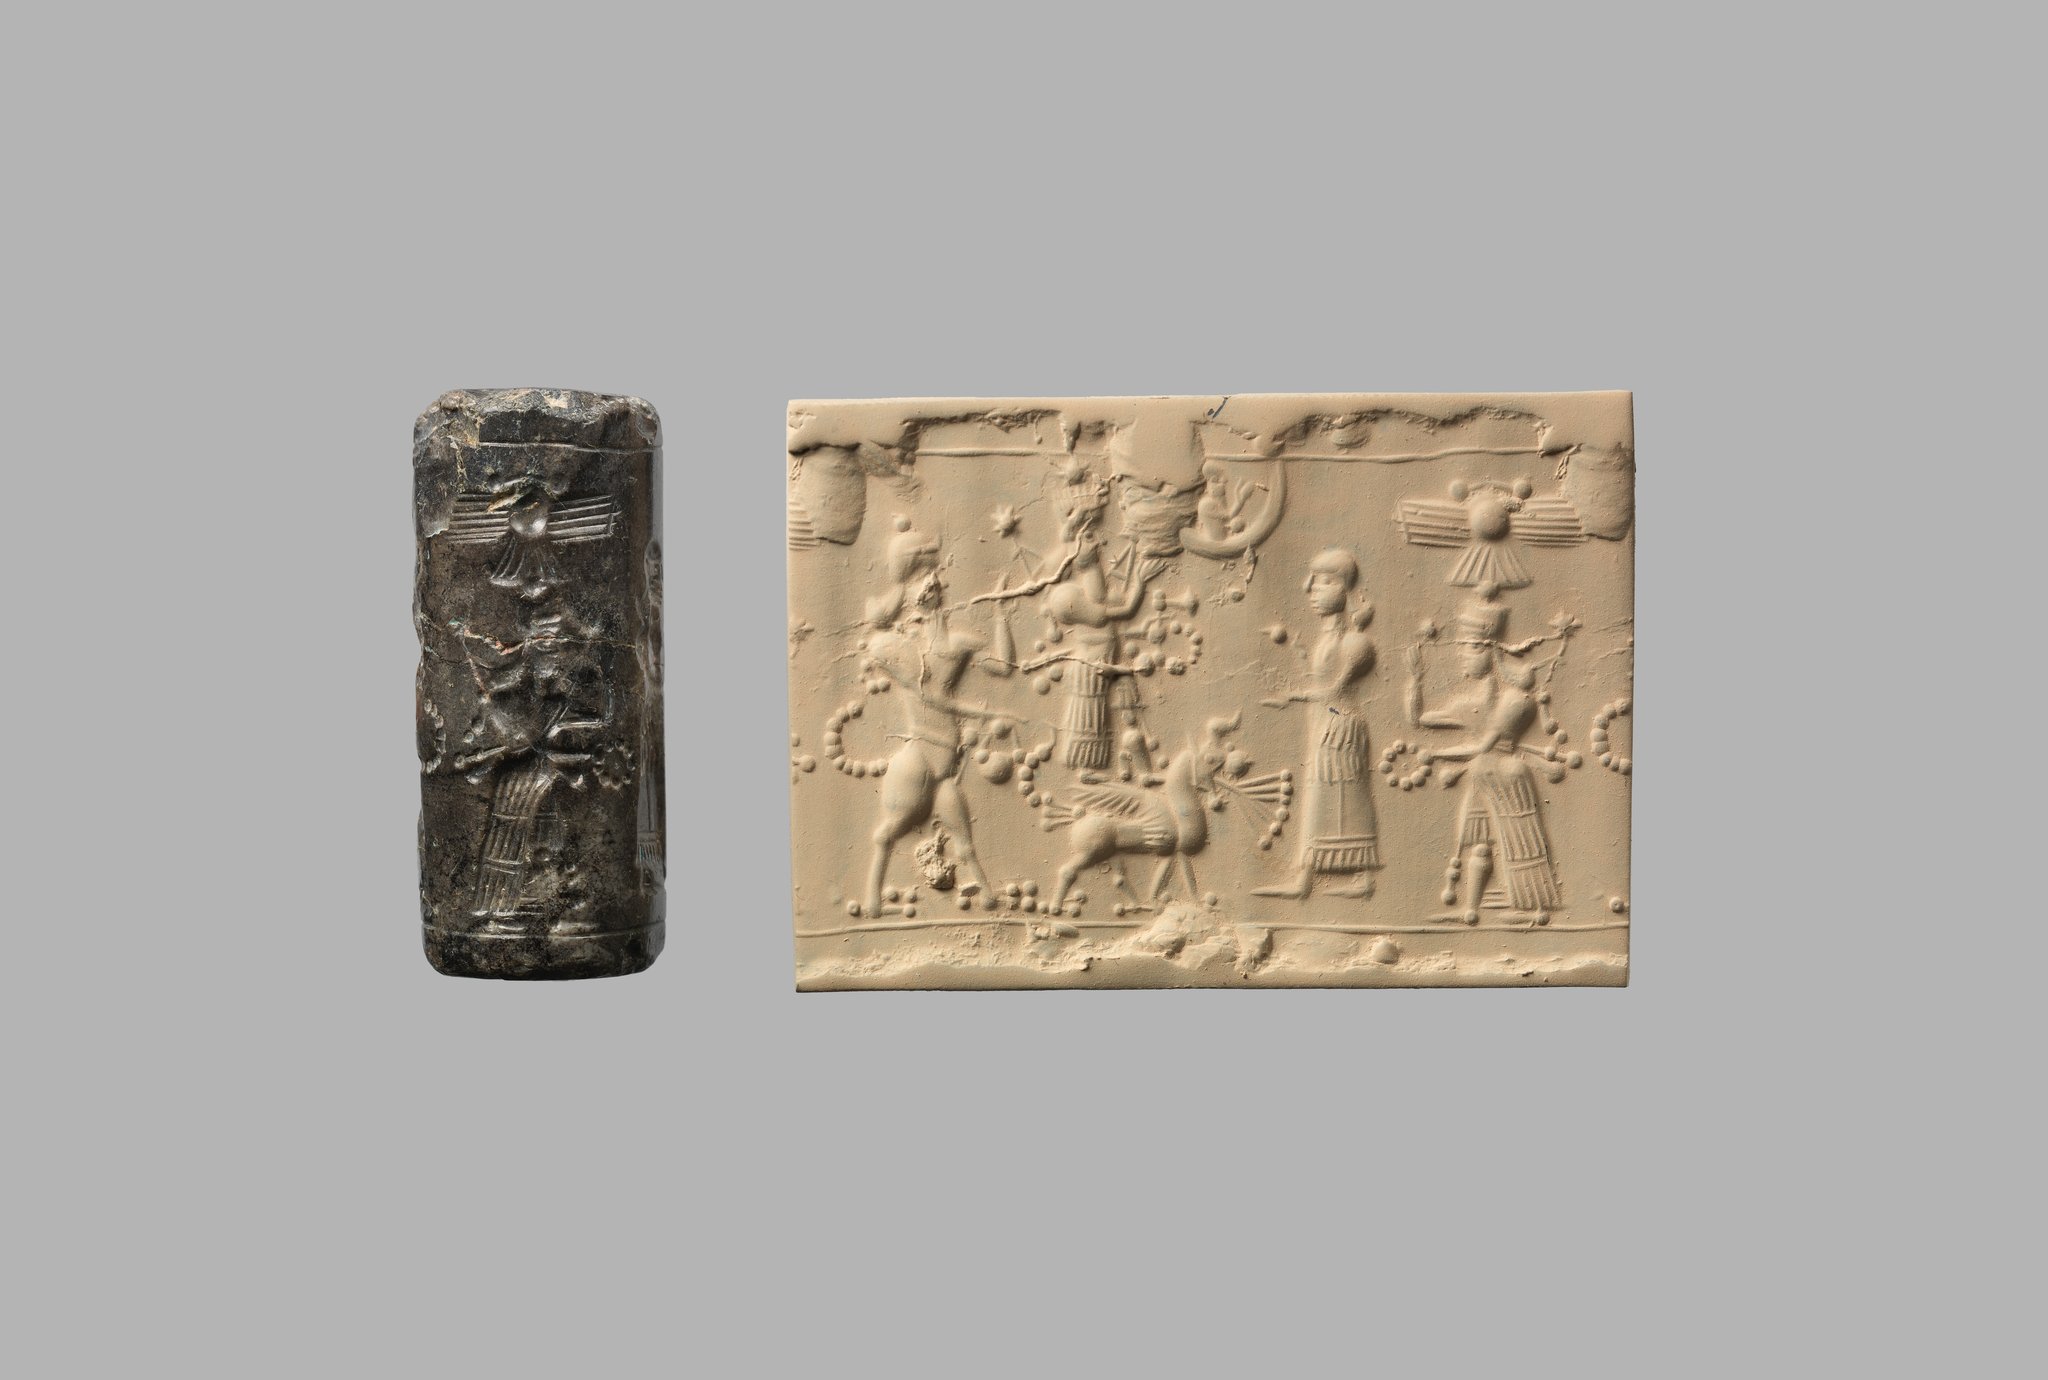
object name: cylinder seal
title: Cylinder seal with cultic scene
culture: assyrian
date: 800-701 BCE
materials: jasper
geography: mesopotamia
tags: men,lions